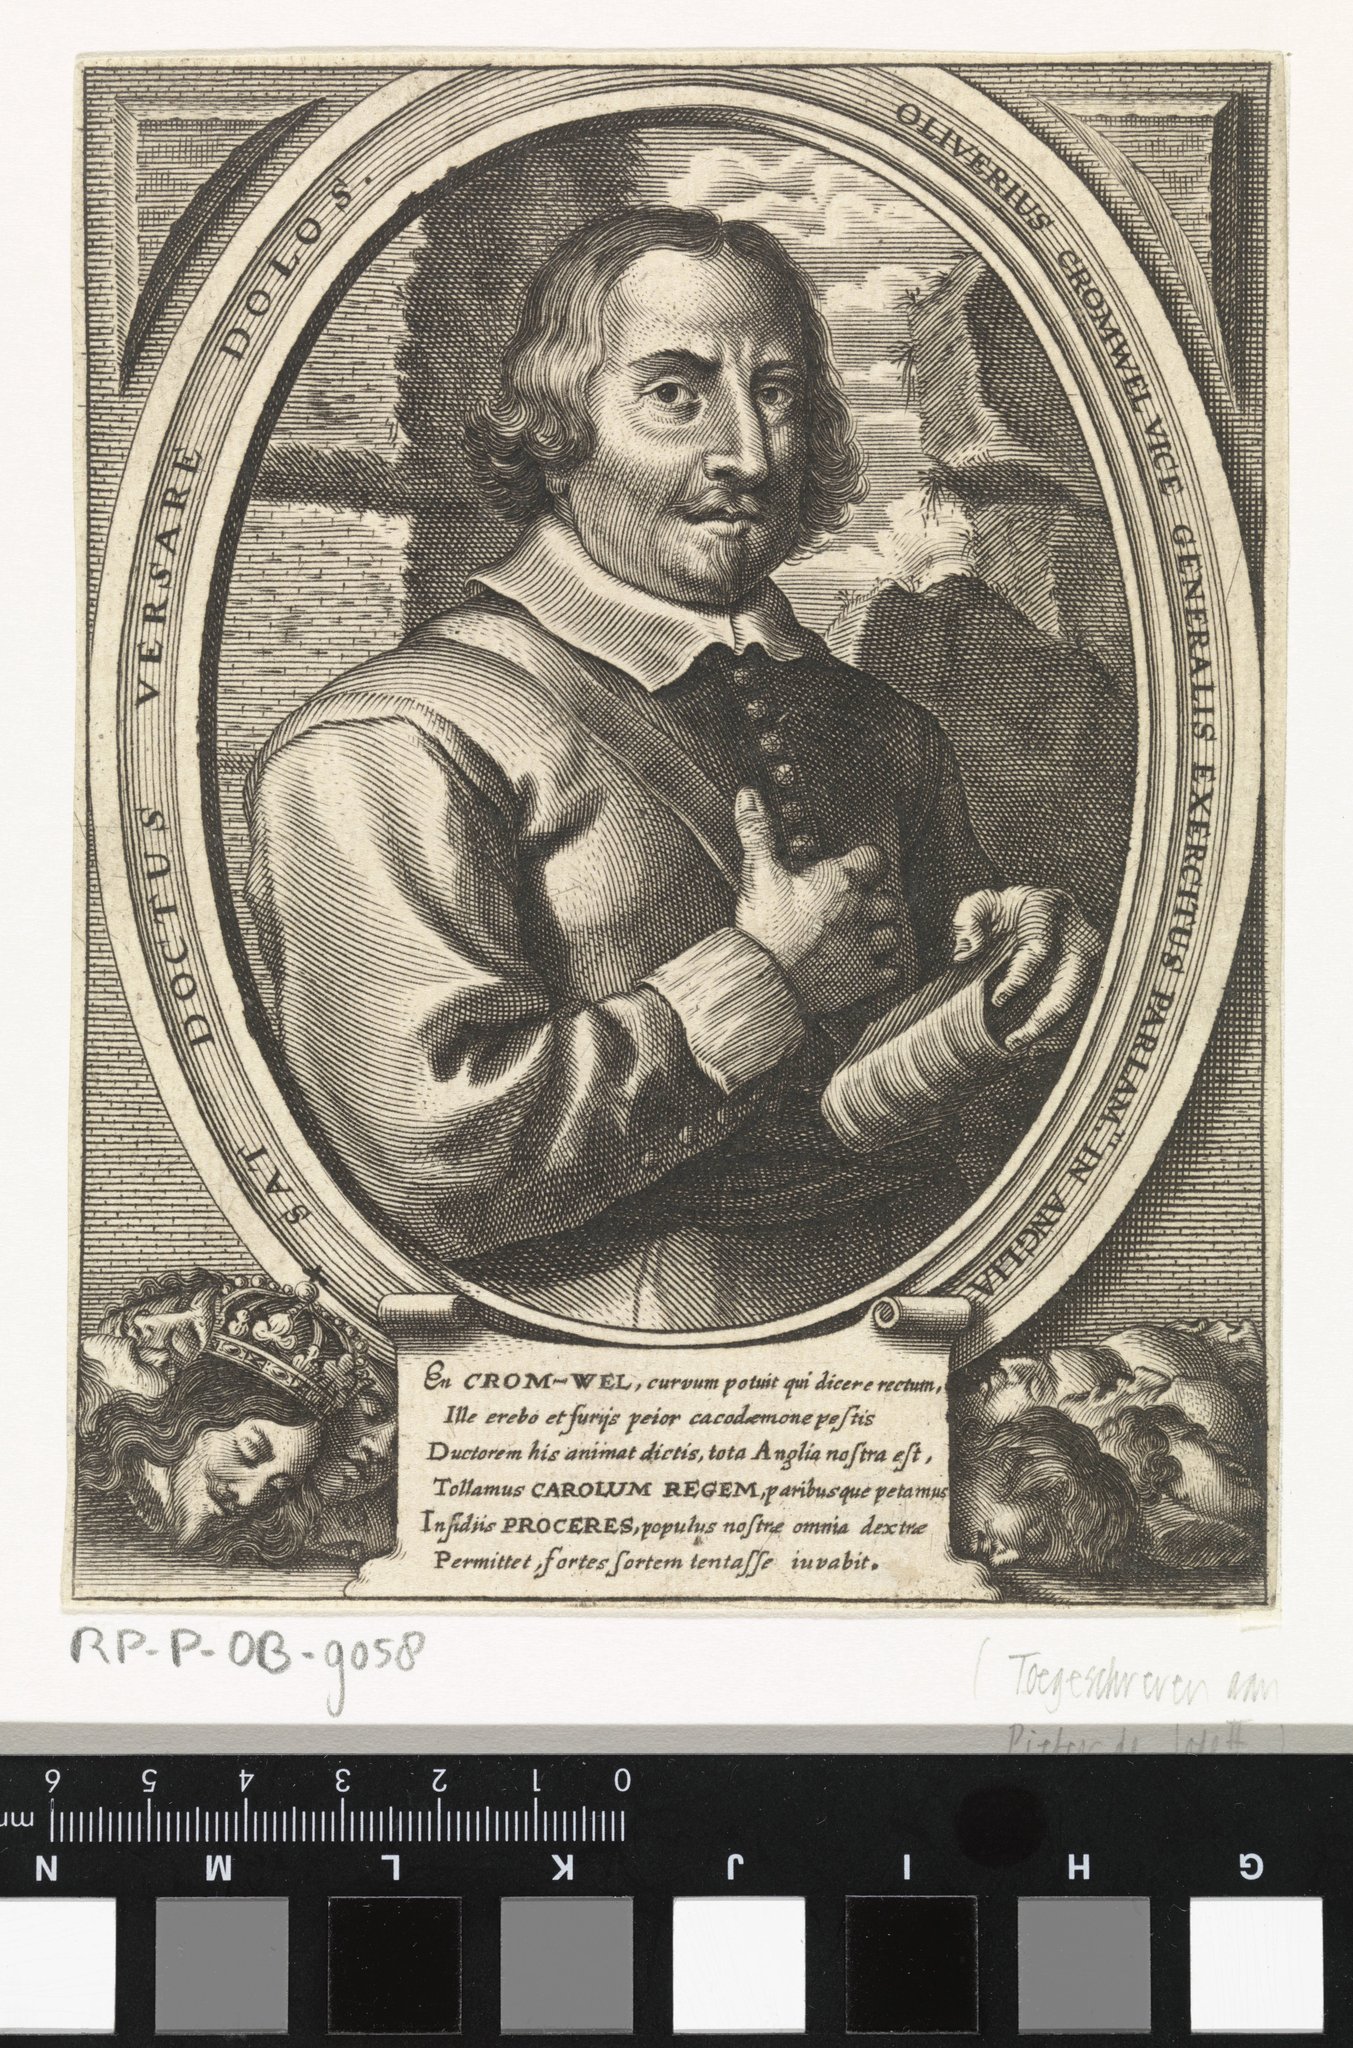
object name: print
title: Portret van Oliver Cromwell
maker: pieter de jode (ii)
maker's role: draughtsman, print maker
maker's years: 1606-1674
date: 1628-1670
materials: paper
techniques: engraving, etching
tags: london, karel i (koning van engeland), oliver cromwell, book, head of a beheaded person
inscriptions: collector's mark: Lugt 2228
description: Portret van Oliver Cromwell, ten halven lijve. In zijn linkerhand houdt hij een boek en zijn rechterhand houdt hij tegen zijn borst. Het portret is gevat in een ovale omlijsting met vierkant randwerk en een randschrift in het Latijn. In het kader een zevenregelig onderschrift in het Latijn. Op de voorgrond afgehakte hoofden van verslagen vijanden, waaronder het hoofd van Karel I.